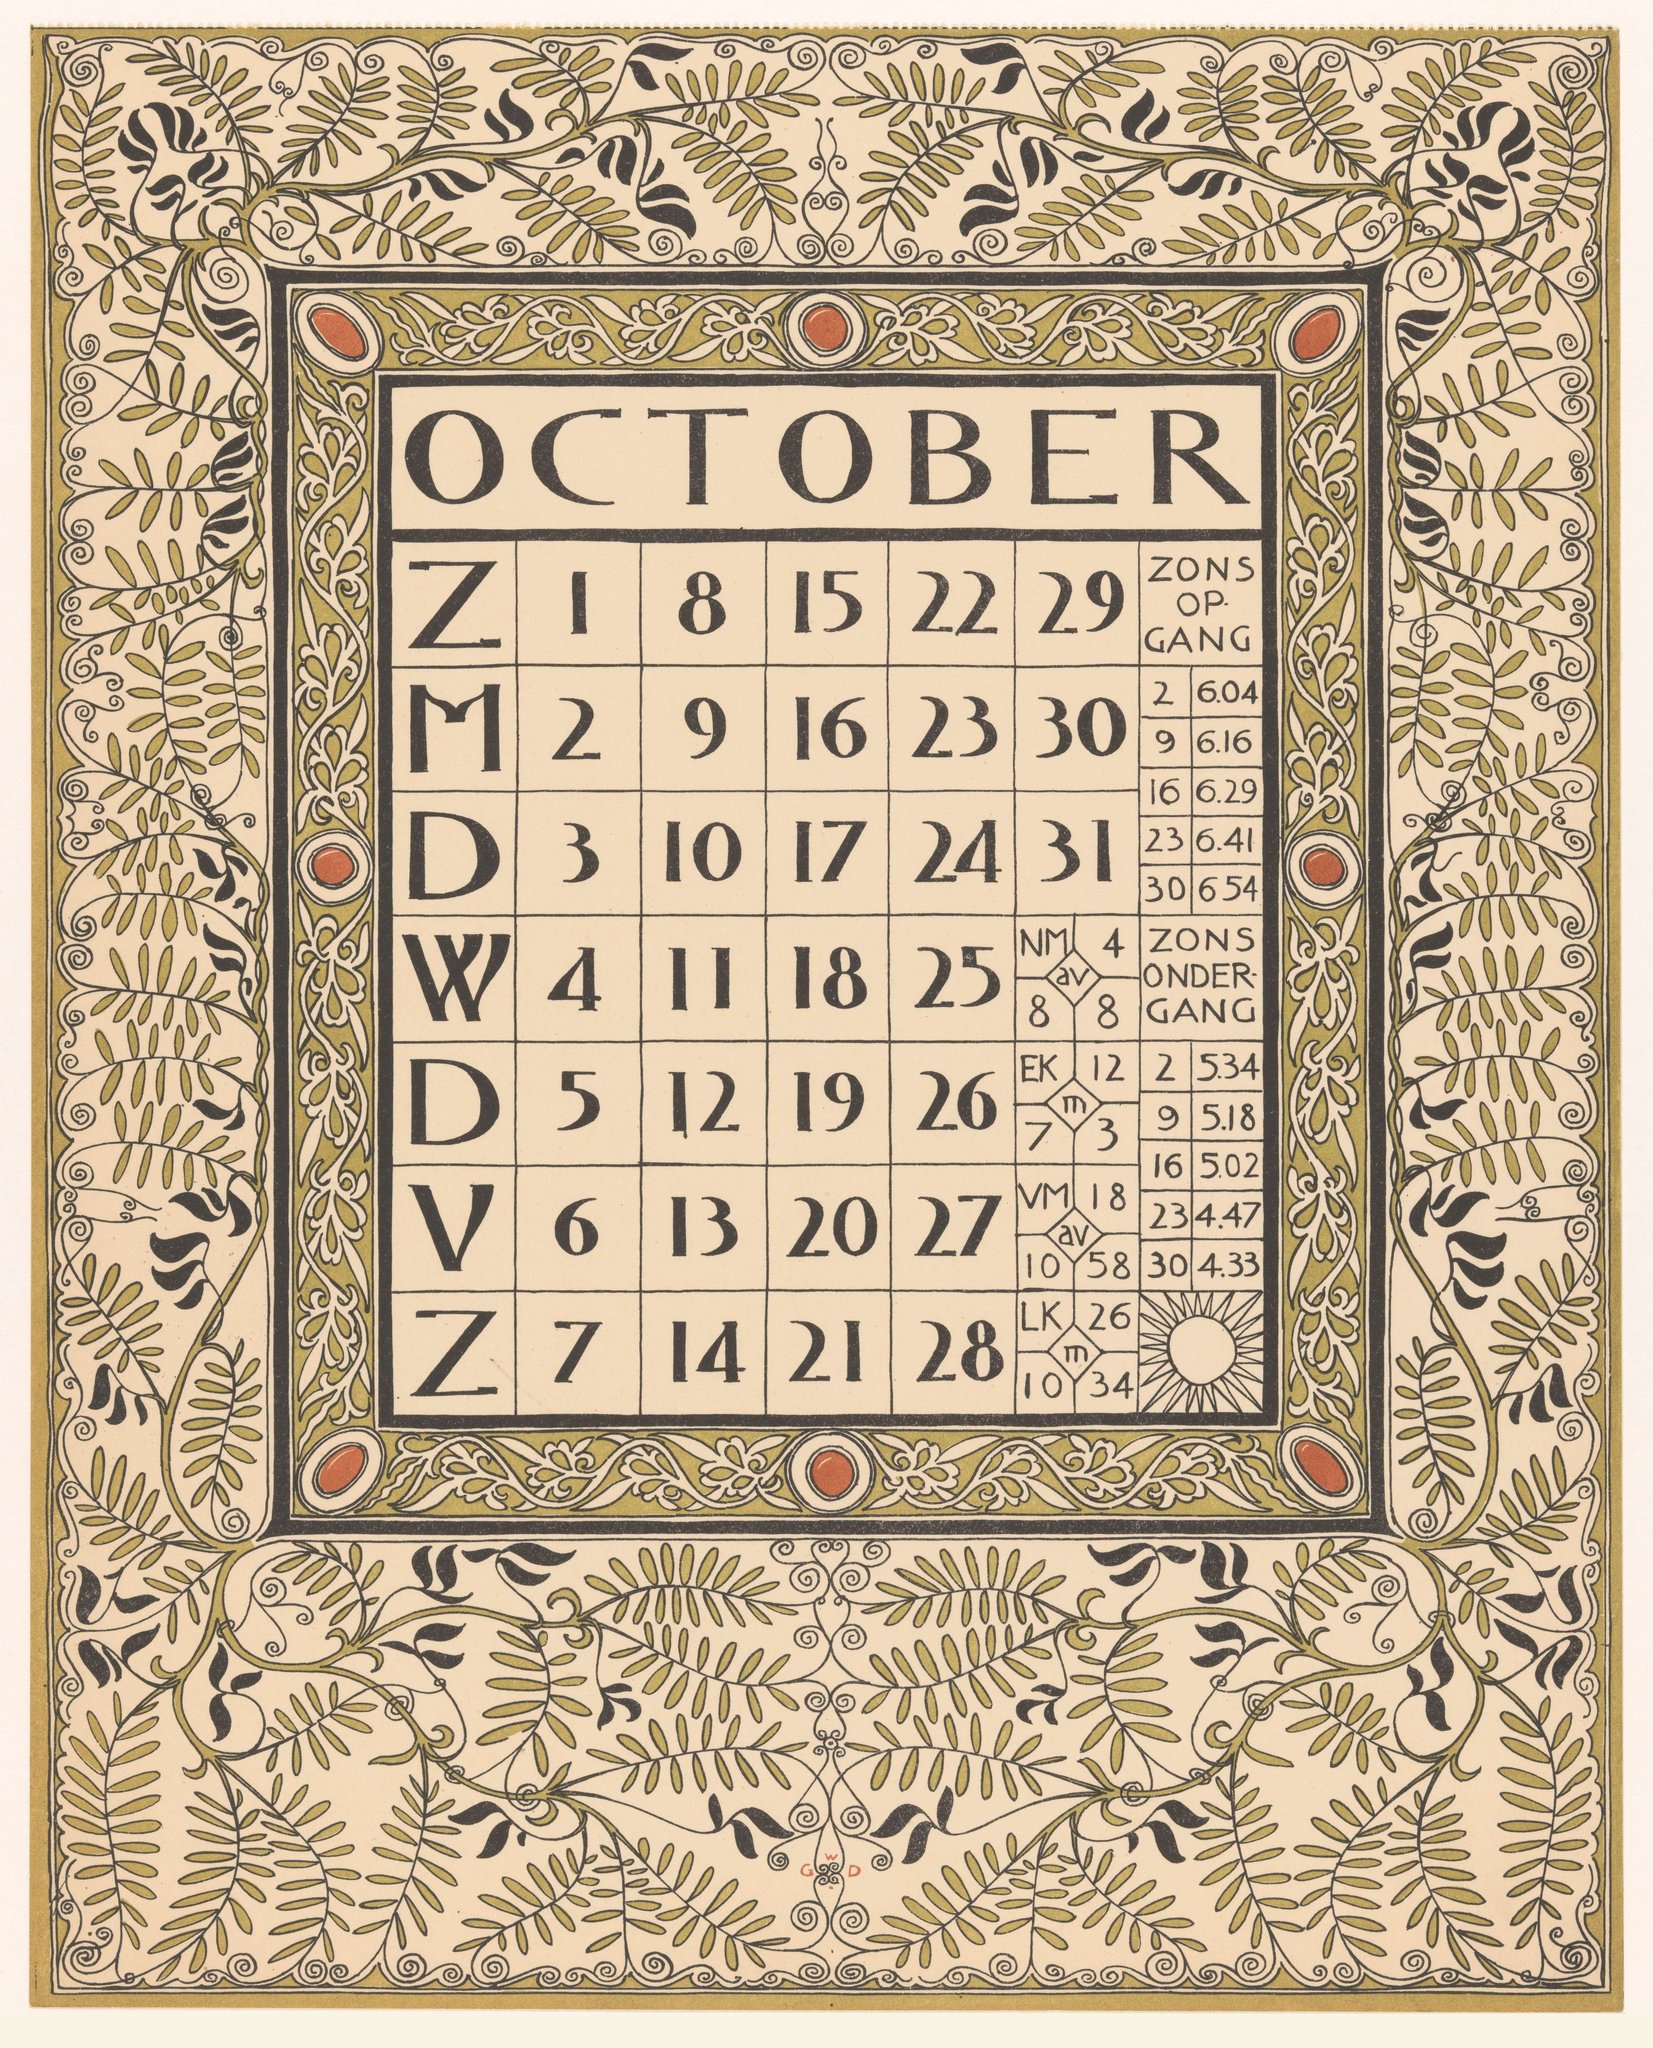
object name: calendar leaf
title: Kalenderblad voor oktober 1899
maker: gerrit willem dijsselhof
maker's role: designer, draughtsman, print maker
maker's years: 1866-1924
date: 1898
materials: paper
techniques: lithograph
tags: foliage, tendrils, branches ~ ornament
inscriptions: collector's mark: Lugt 2228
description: In 1898 vervaardigden Gerrit Willem Dijsselhof, Carel Adolph Lion Cachet en Theo Nieuwenhuis samen een kalender voor het jaar 1899. Dijsselhof nam het ontwerp van de maanden januari, april, juli en oktober op zich.